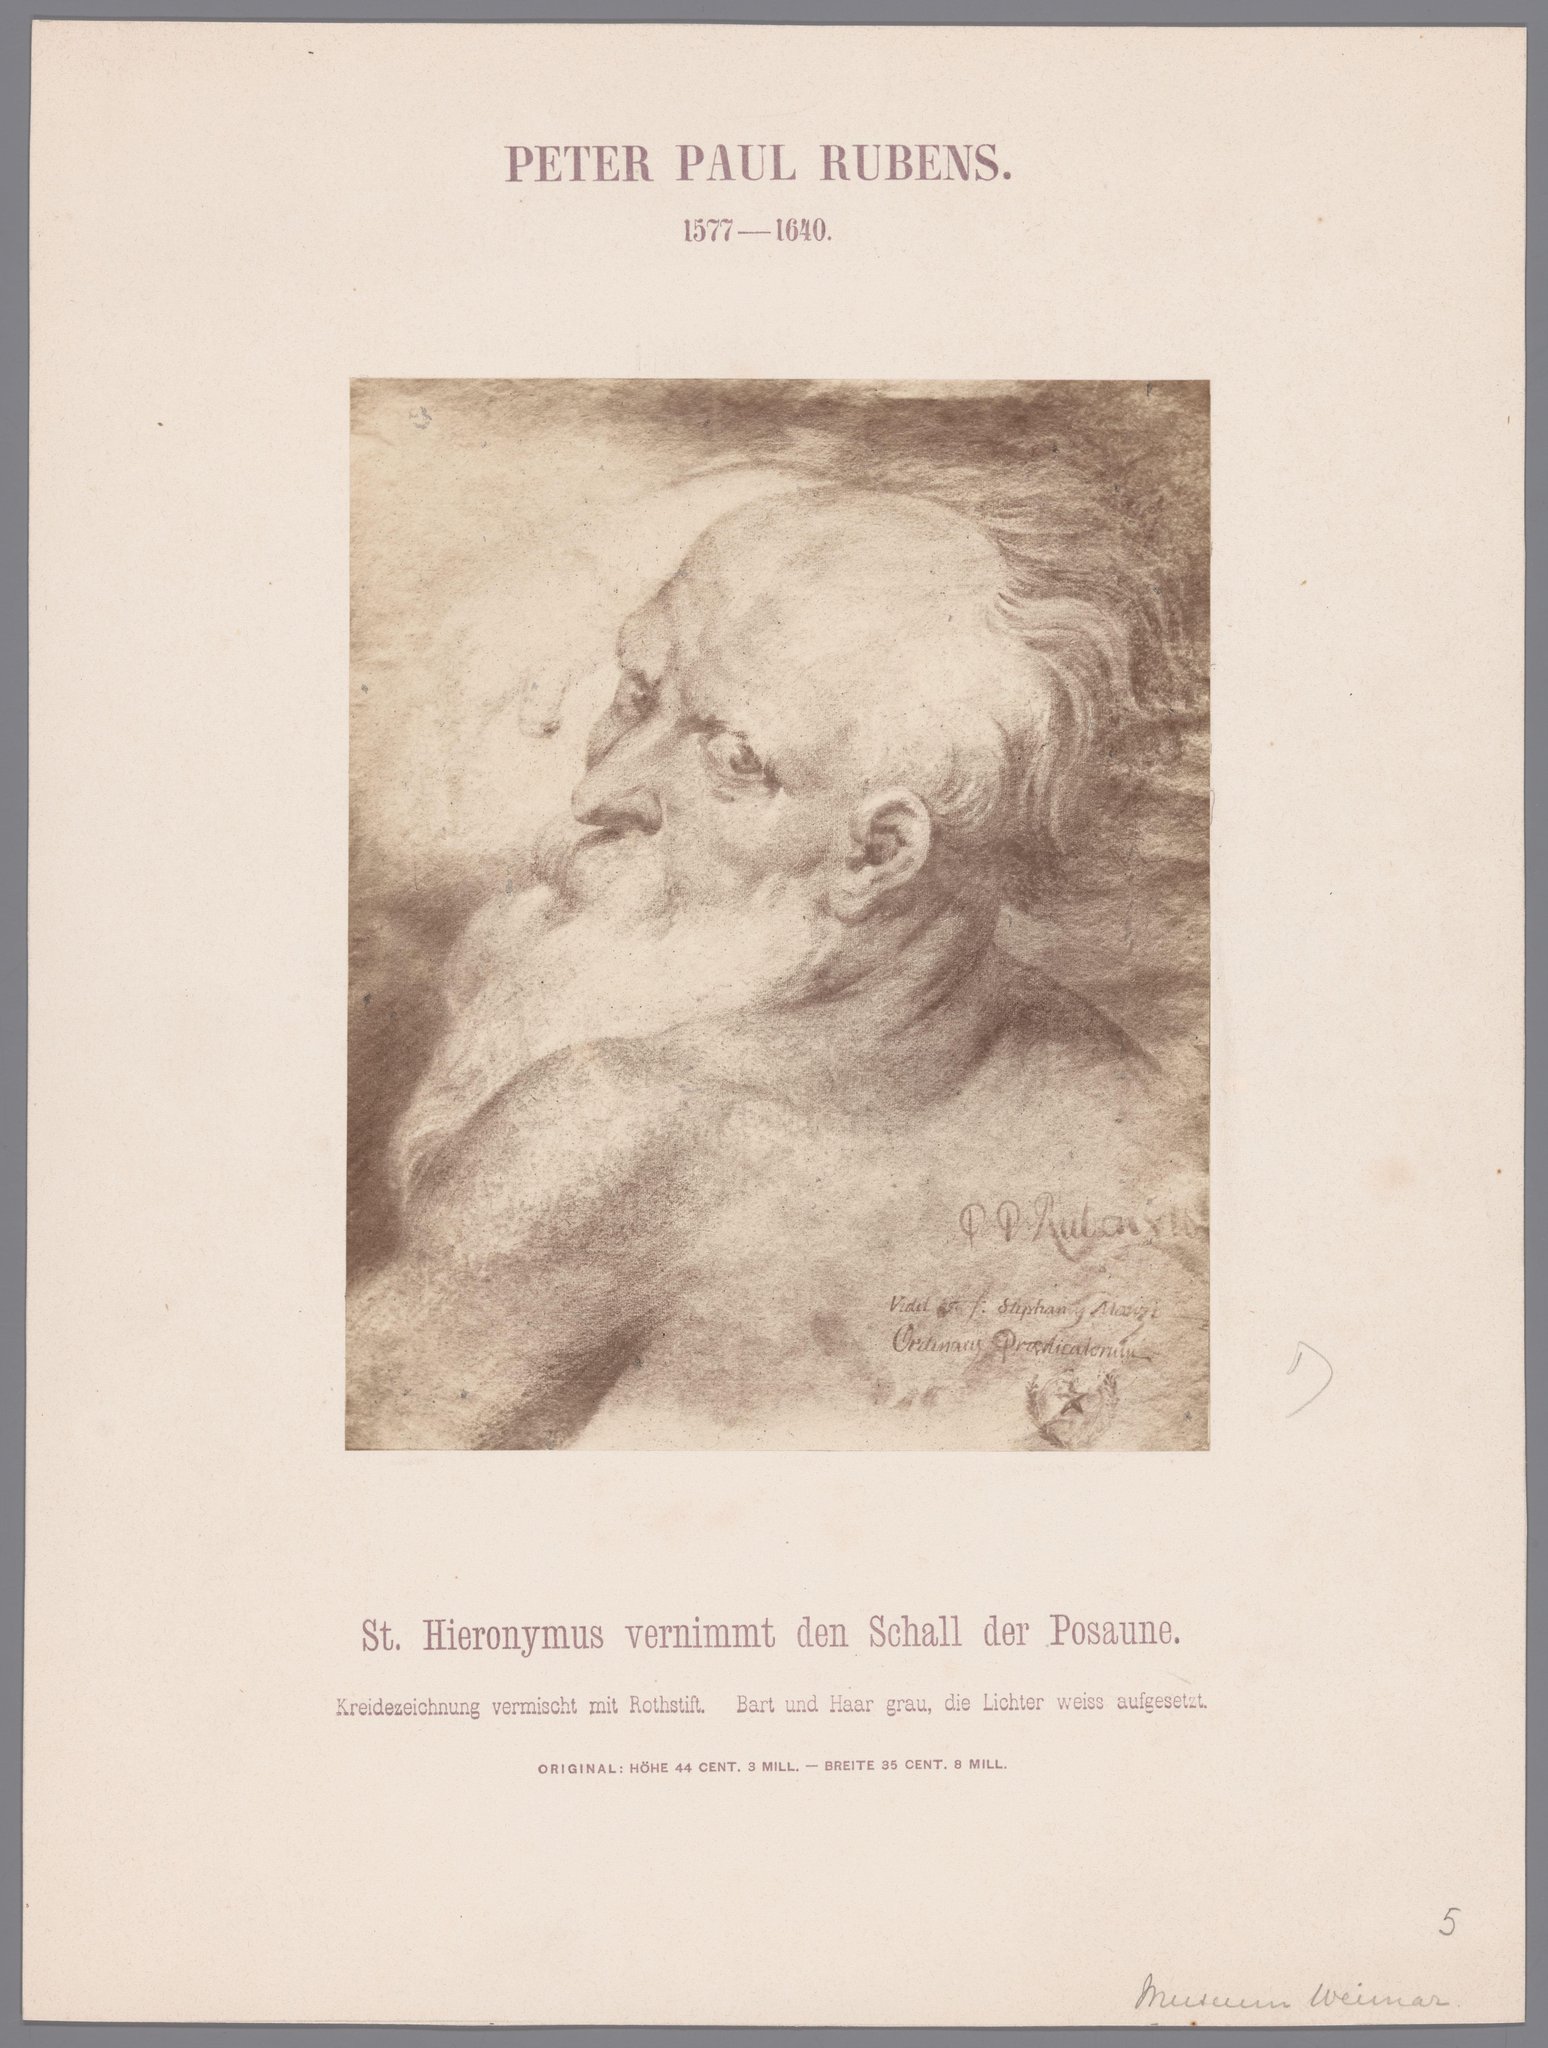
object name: photograph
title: St. Hieronymus vernimmt den Schall der Posaune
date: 1870-1890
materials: cardboard, paper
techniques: albumen print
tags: drawing, sketch, the monk and hermit jerome (hieronymus); possible attributes: book, cardinal's hat, crucifix, hour-glass, lion, skull, stone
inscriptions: inscription: ‘Kreidezeichnung vermischt mit Rohtstift. Bart und Haar grau, die Lichter weiss aufgesetzt./ ORIGINAL: HÖHE 44 CENT. 3 MILL. - BREITE 35 CENT. 8 MILL.’, inscription: ‘5/ museum Weimar.’, inscription: ‘PETER PAUL RUBENS./ 1577-1640.’